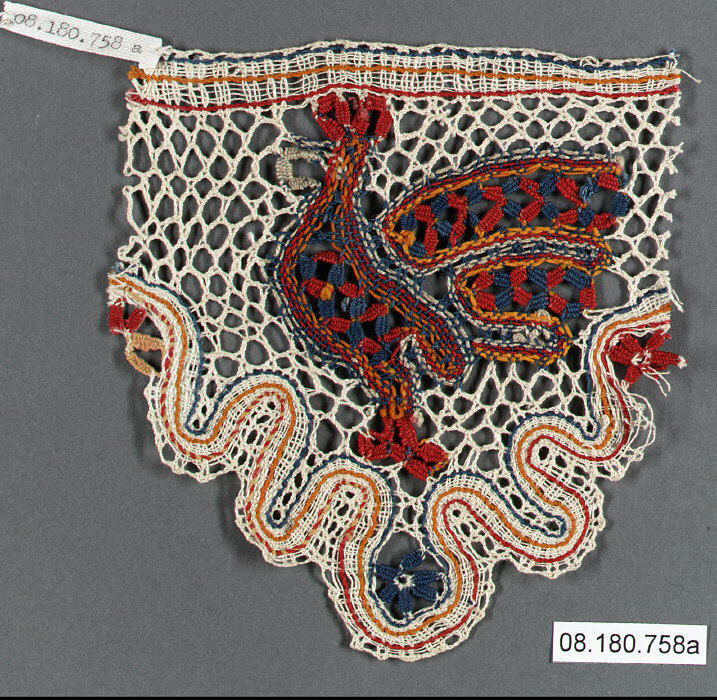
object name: fragment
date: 1801-1900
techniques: lace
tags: birds